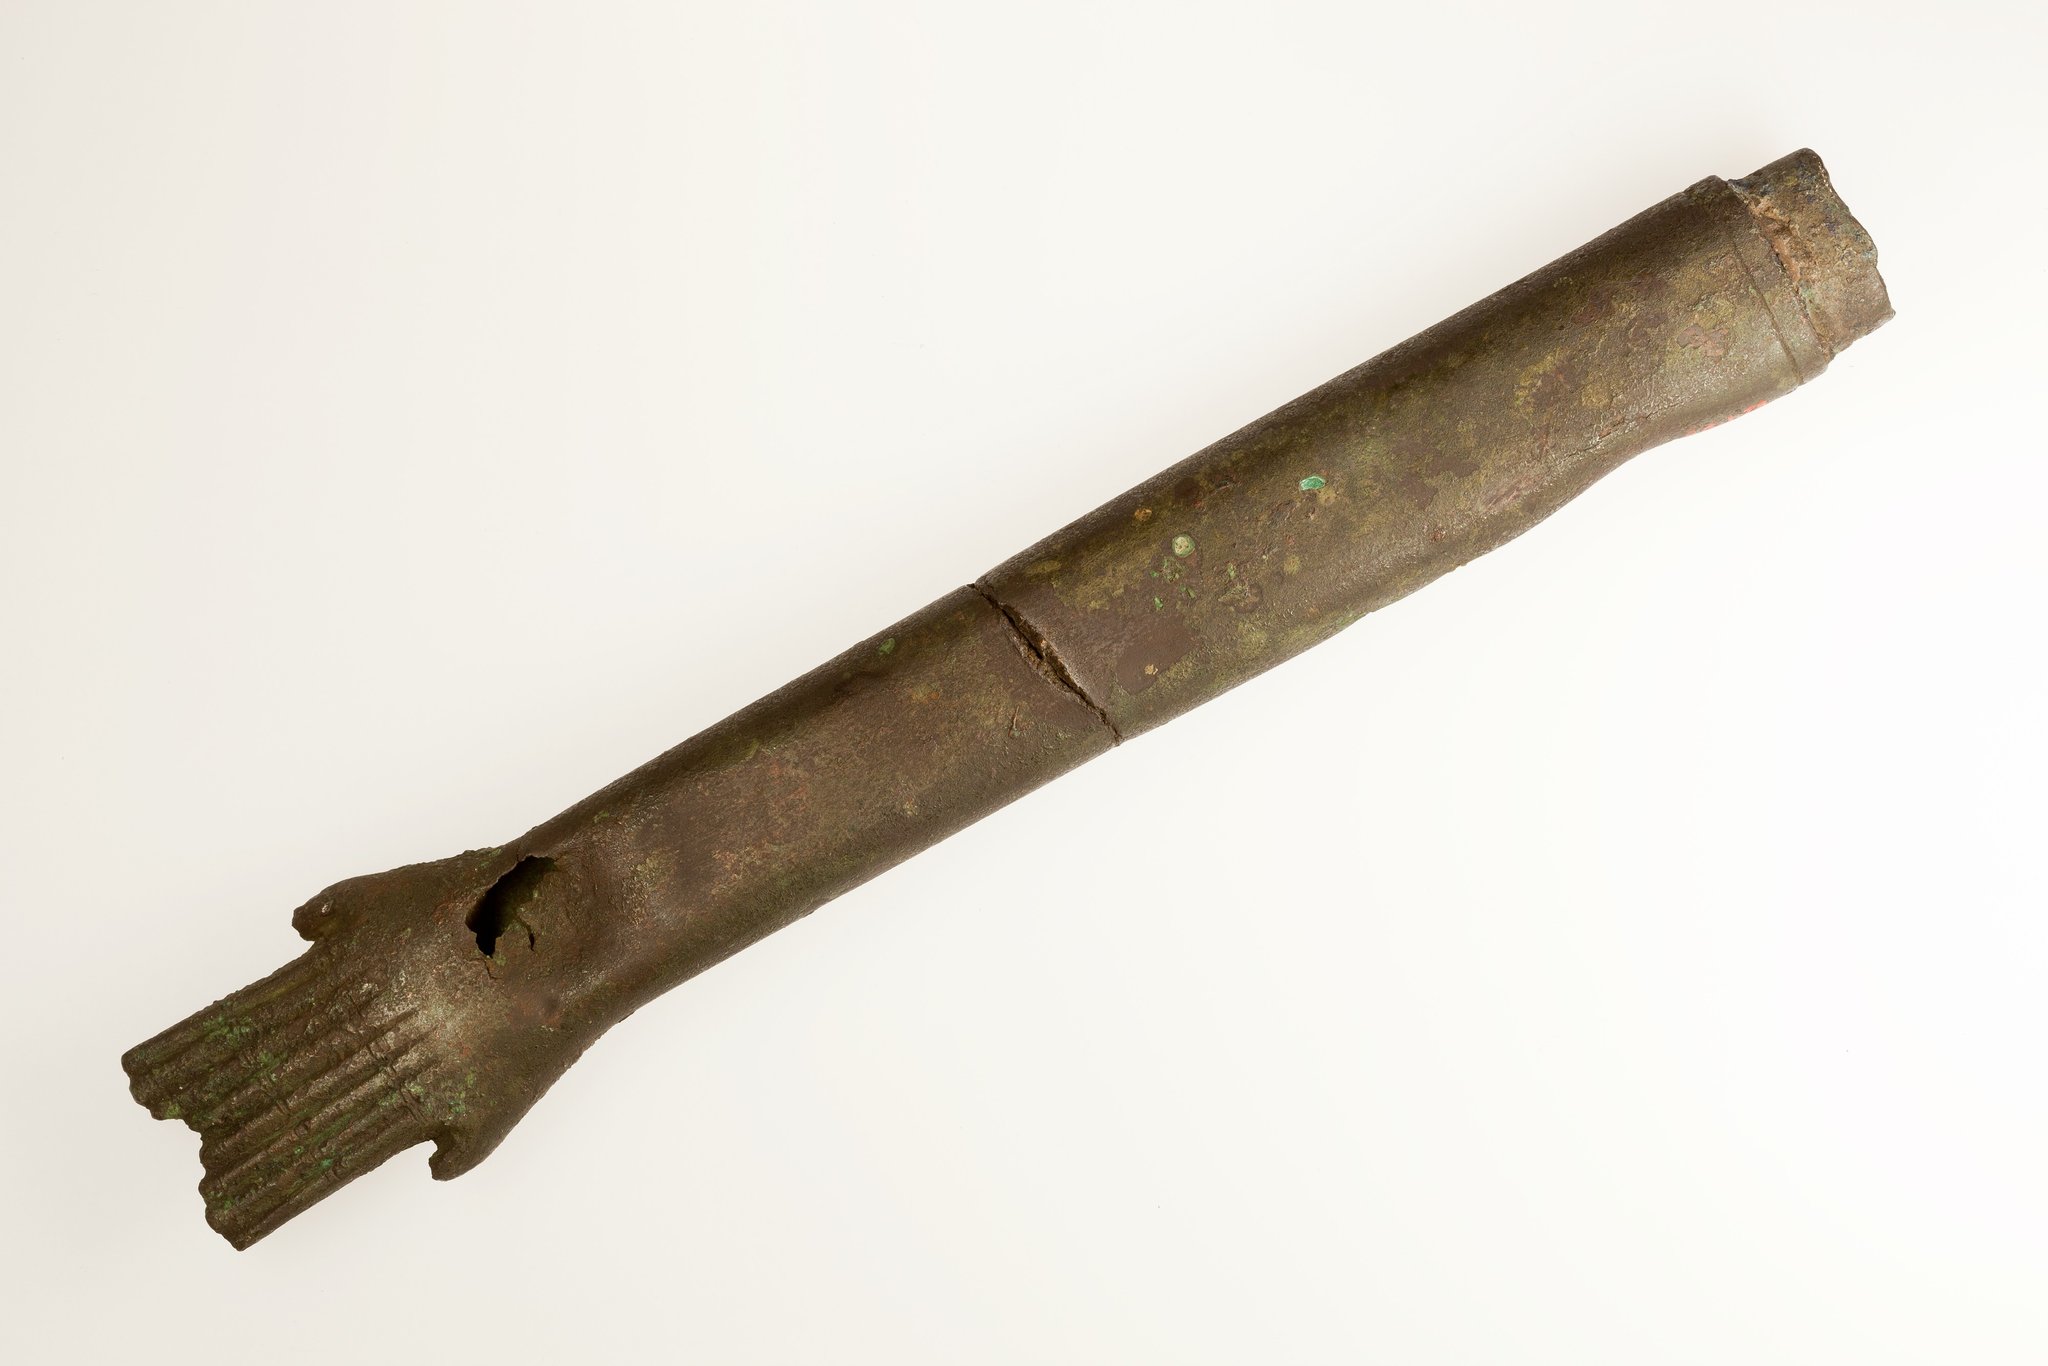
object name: censer fragment, hand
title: A portion of a censer? in the shape of a hand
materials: bronze, copper alloy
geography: egypt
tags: hands